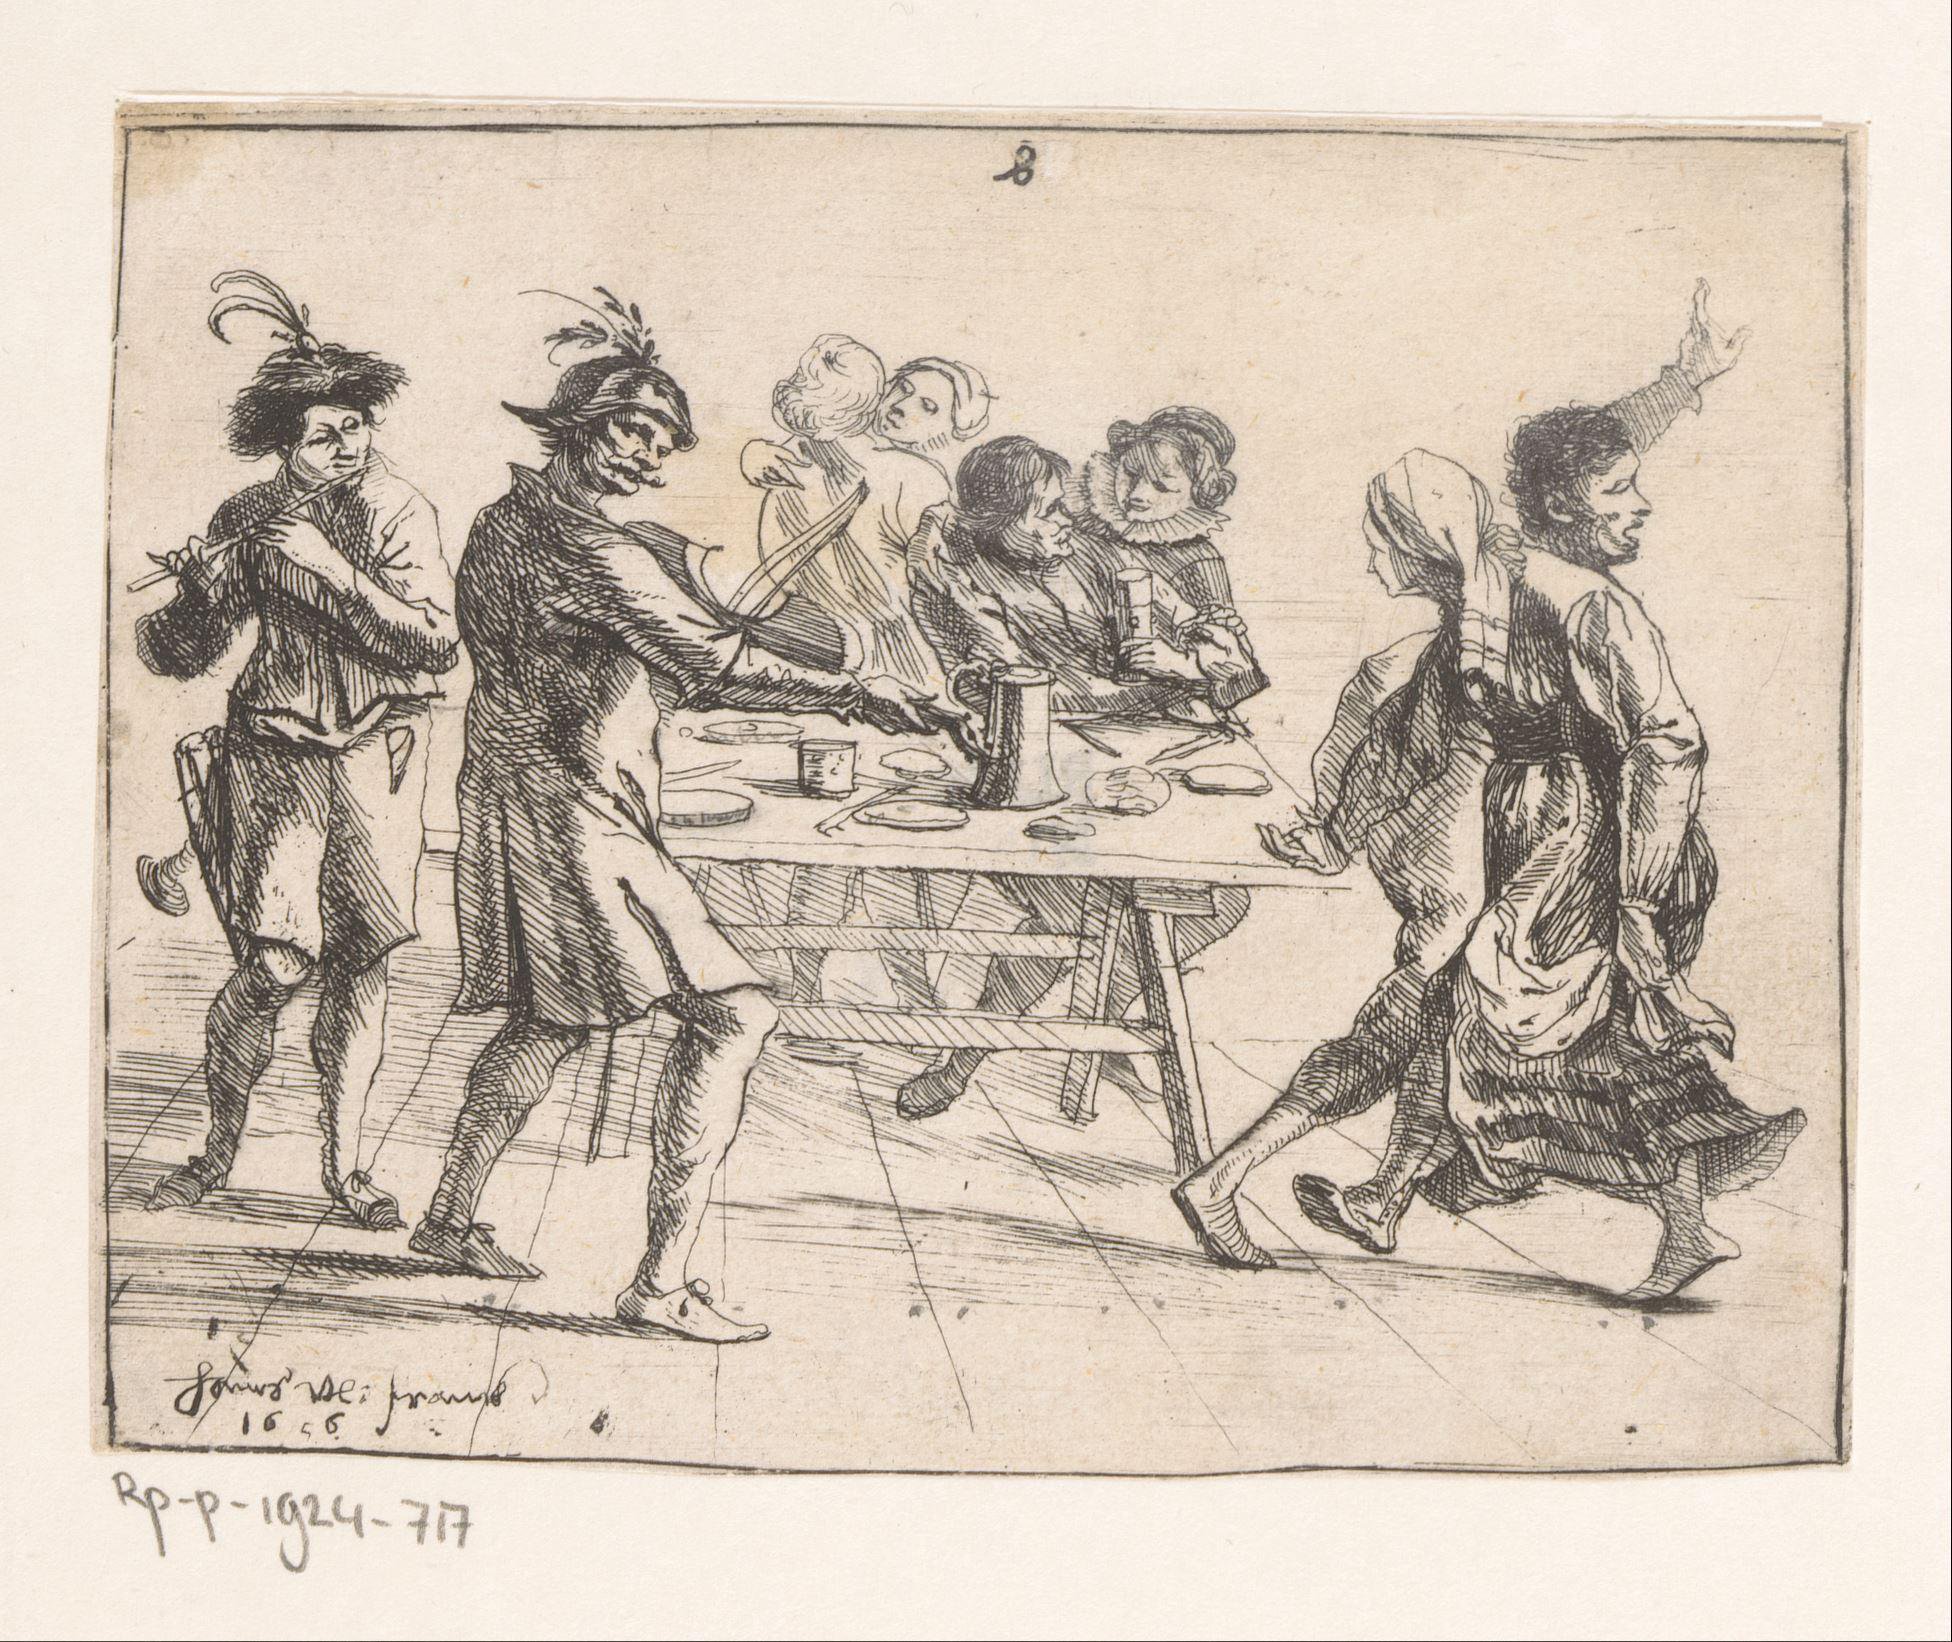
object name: print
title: Muzikanten en dansende soldaten in een herberg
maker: hans ulrich franck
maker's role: draughtsman, print maker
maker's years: 1603-1680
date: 1656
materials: paper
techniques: etching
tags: making music; musician with instrument, one pair dancing; man and woman dancing as a couple, hotel, hostelry, inn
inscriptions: collector's mark: Lugt 2166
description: Prent uit een serie van vijfentwintig militaire voorstellingen, waarvan tien in de collectie van het RMA aanwezig zijn.